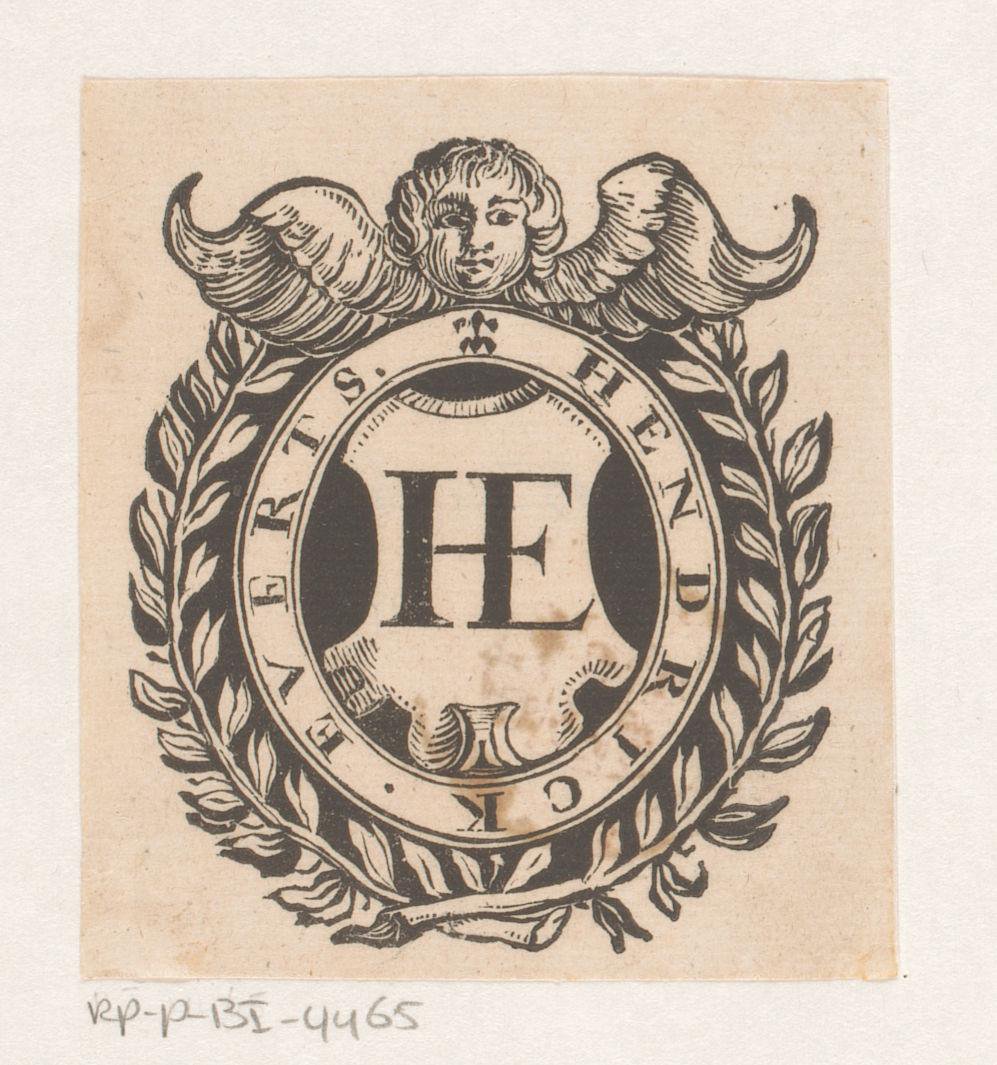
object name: print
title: Vignet van Hendrick Everts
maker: Anonymous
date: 1600-1699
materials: paper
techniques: woodcut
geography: netherlands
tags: cherubs, i.e. children's heads with wings, vignette, letter combinations such as letterword, anagram, letter square, monogram, etc.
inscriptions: collector's mark: Lugt 240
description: Het monogram van Hendrick Everts in een ovaal met randschrift. Midden boven een cherubijn.